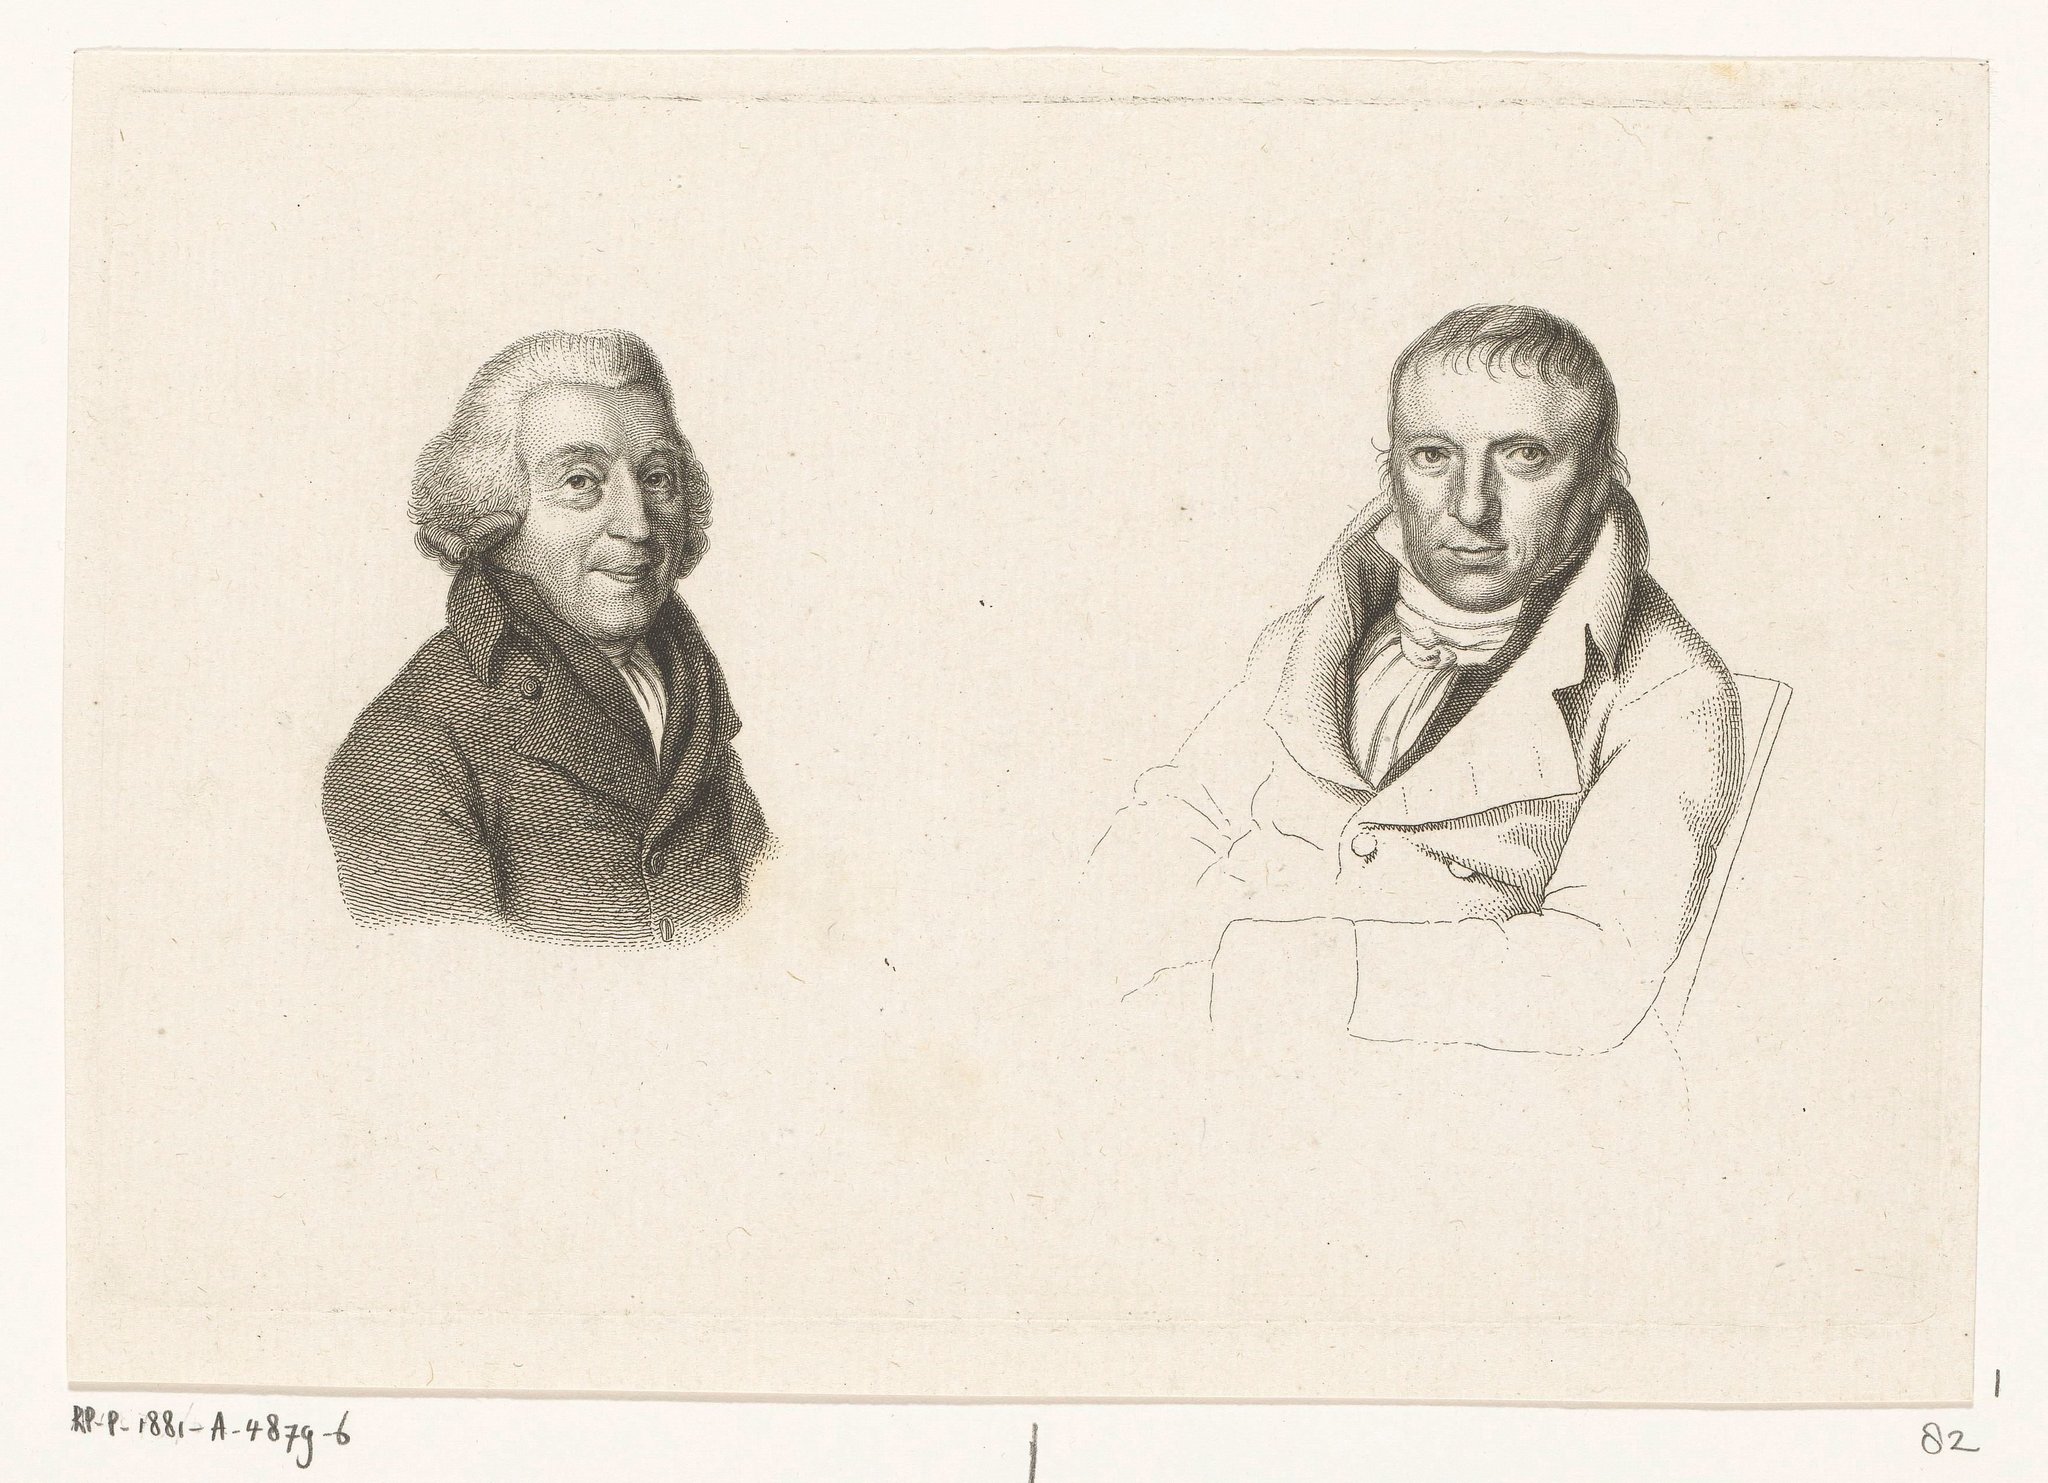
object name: print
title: Portretten van Joannes Wilmet en Johannes Kinker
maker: jacob ernst marcus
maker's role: draughtsman, print maker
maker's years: 1774-1826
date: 1814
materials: paper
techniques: etching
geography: amsterdam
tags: amsterdam, johannes kinker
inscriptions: collector's mark: Lugt 2228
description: Latere staat van de prent gebruikt in: Jacob Ernst Marcus, Etudes gravées. Amsterdam: S. de Grebber, 1826.